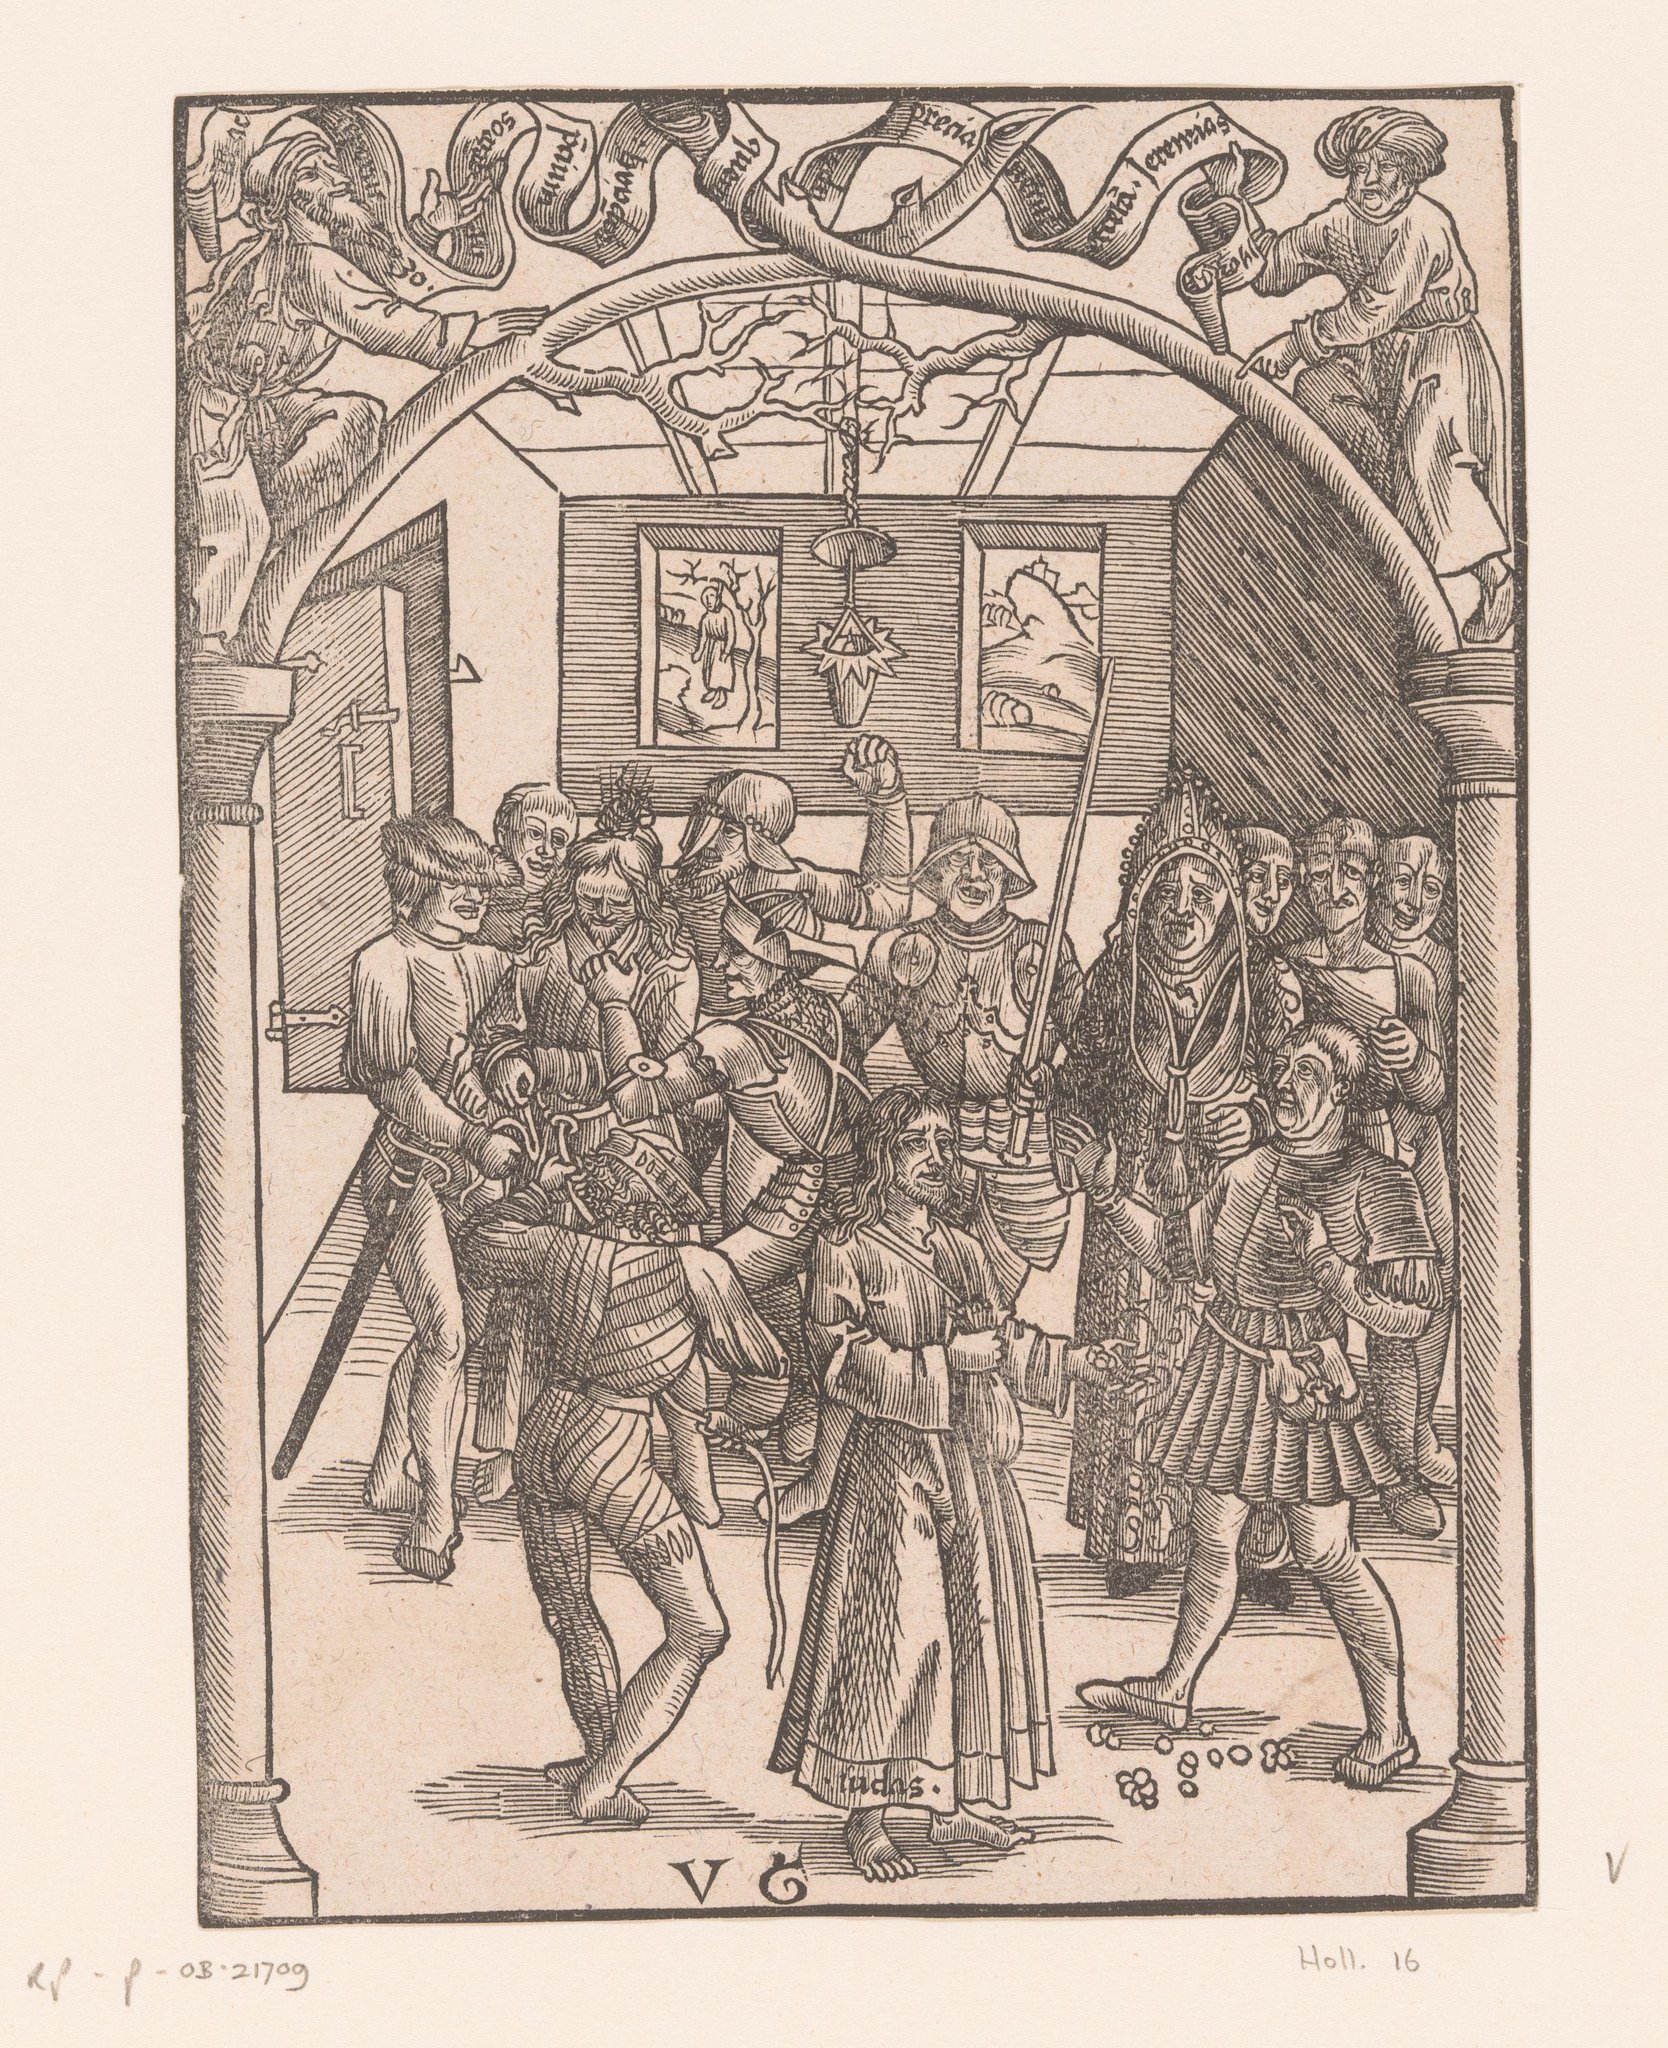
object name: print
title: Passie van Christus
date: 1506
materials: paper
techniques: woodcut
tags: in pilate's palace christ is mocked by soldiers (luke 22:63-65), judas before the sanhedrin returning the pieces of silver; he throws the money to the ground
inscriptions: collector's mark: Lugt 240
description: Afkomstig uit: Der Text des Passions oder Lidens Christi (...). Straatsburg: N. Ringmann, 1506.